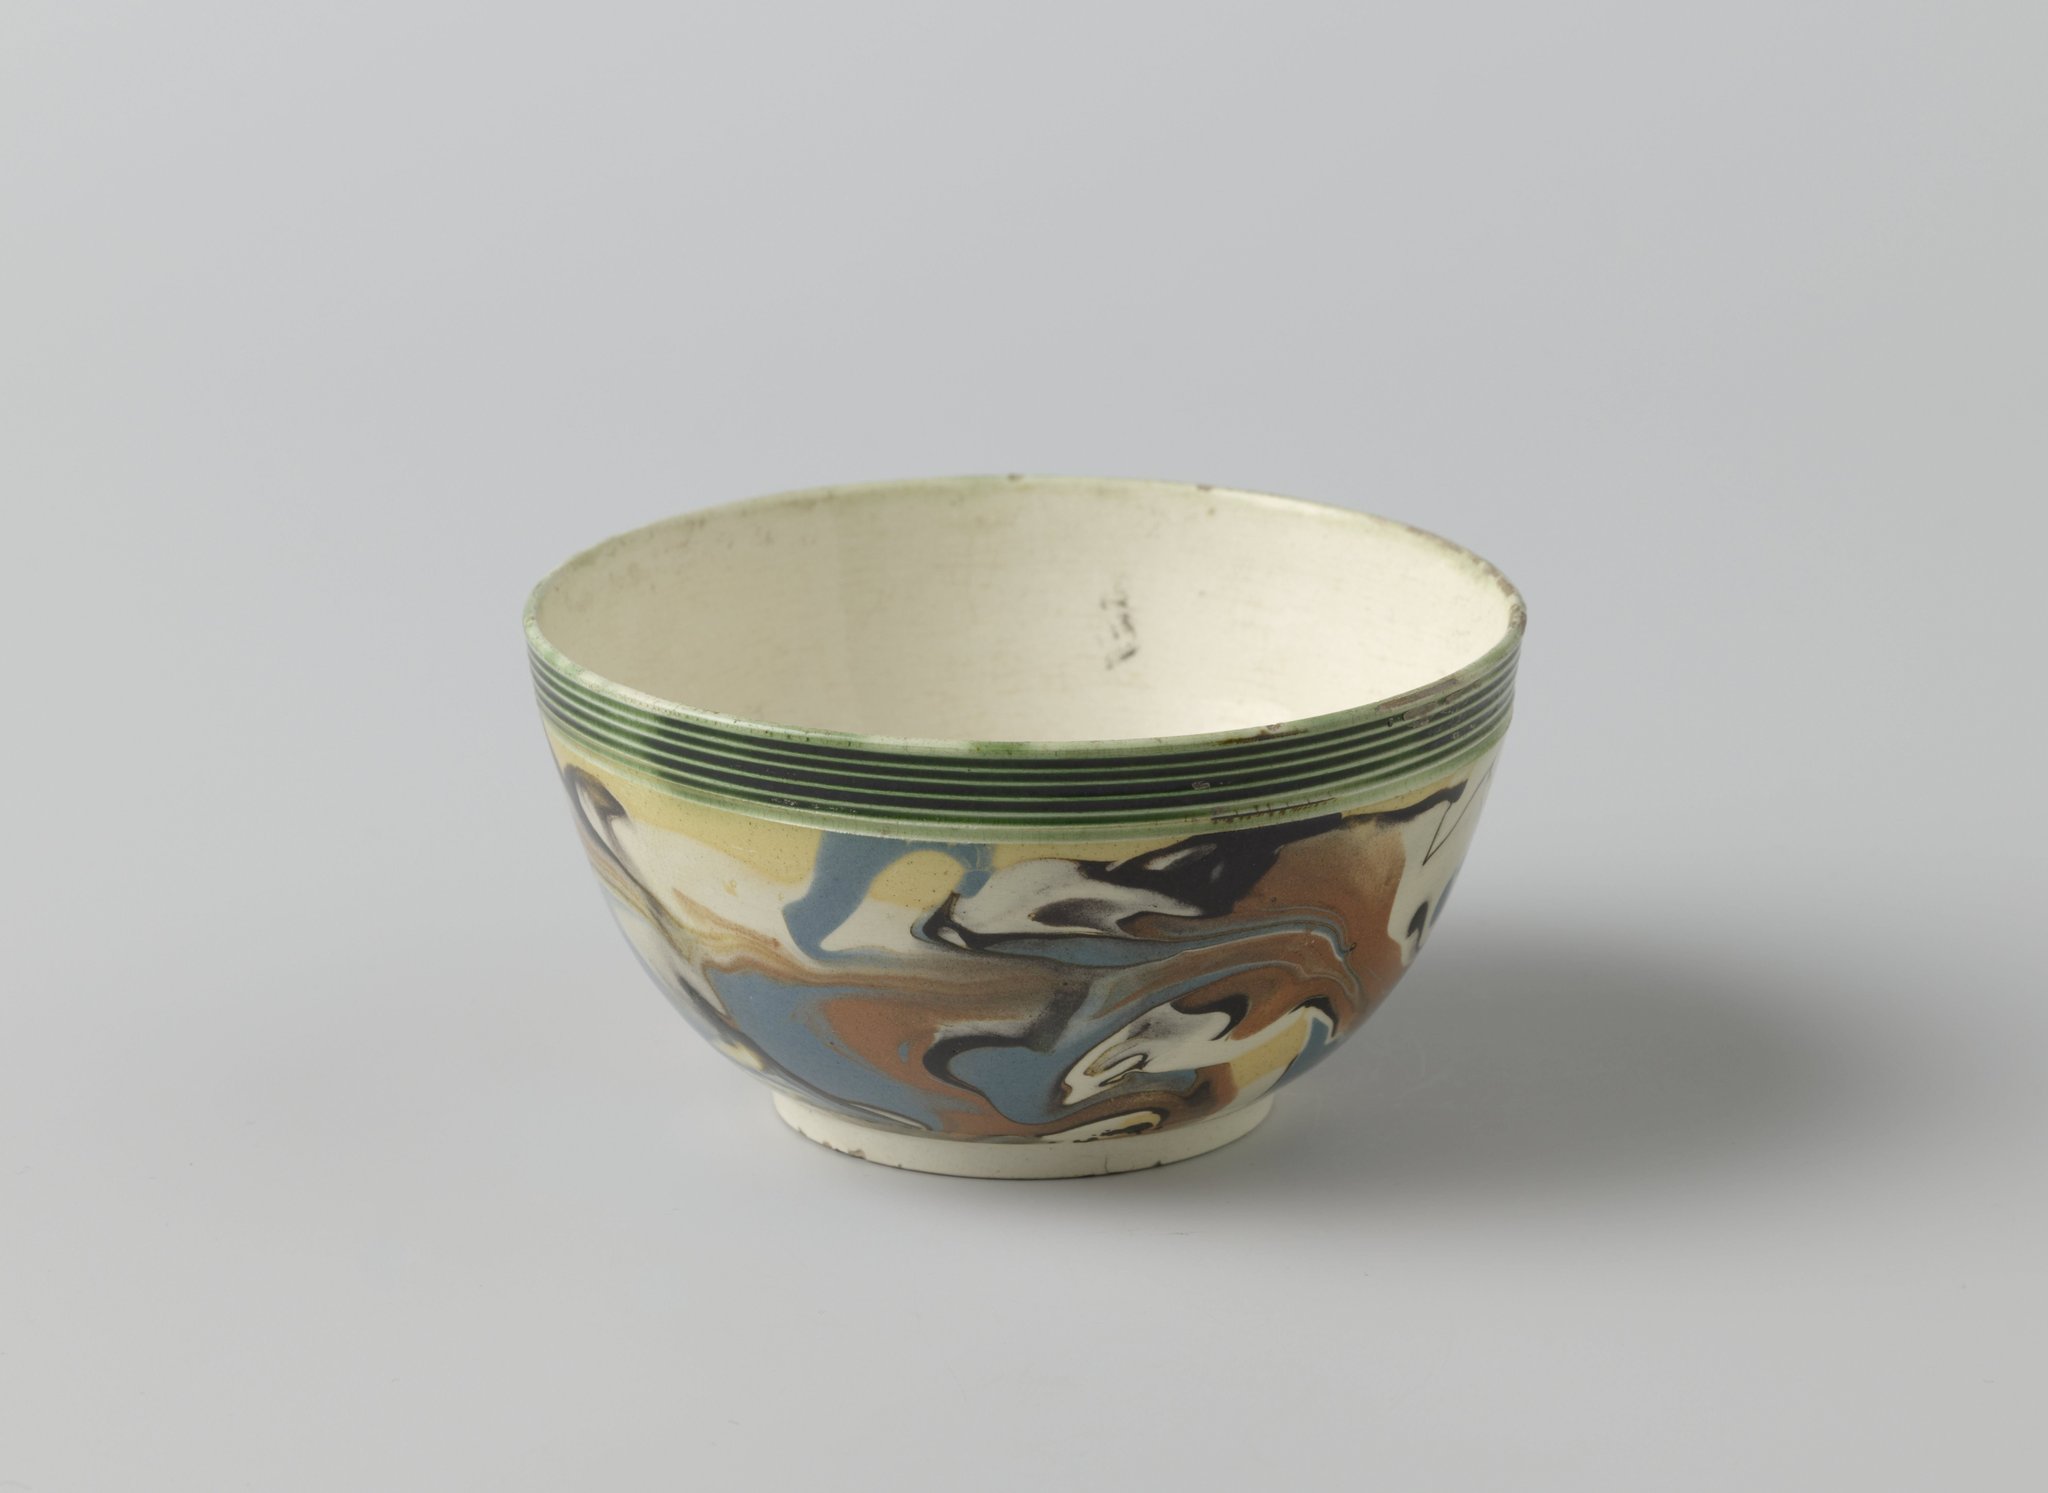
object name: cup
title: Kop van hardgebakken aardewerk, creamware met gemarmerde decoratie.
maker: Anonymous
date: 1780-1820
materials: earthenware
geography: staffordshire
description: Halfbolvormige kop van hardgebakken aardewerk. De buitenzijde van de kop heeft een gemarmerde decoratie in wit, blauw, zwart, rood en geel.